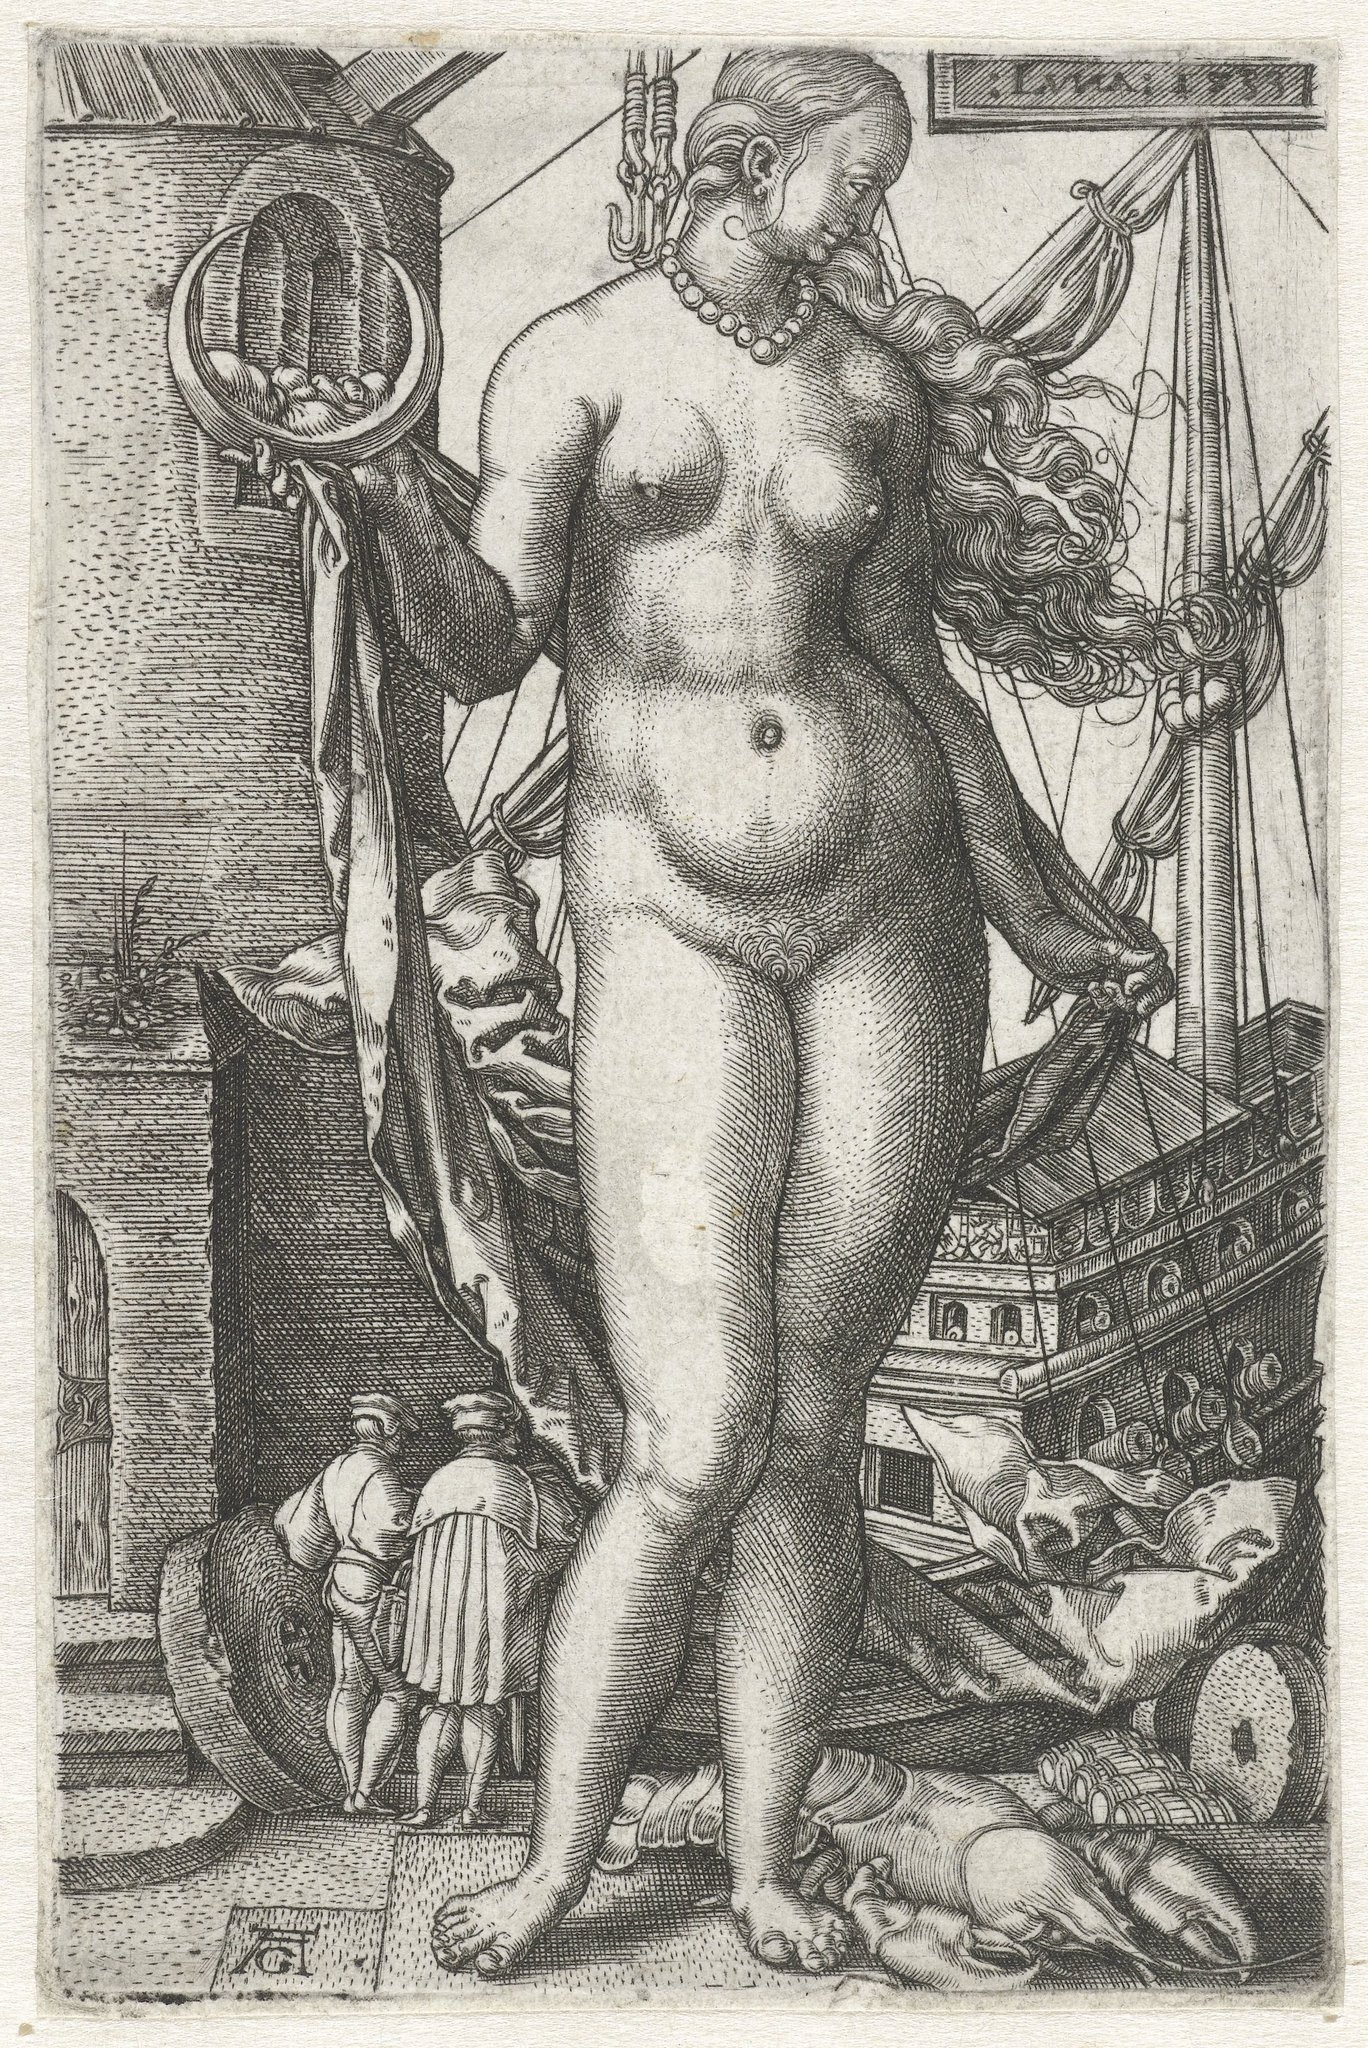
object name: print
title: Diana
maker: heinrich aldegrever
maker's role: draughtsman, print maker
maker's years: 1502-1561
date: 1533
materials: paper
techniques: engraving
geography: germany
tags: diana as moon-goddess, i.e. luna (selene)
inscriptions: date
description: Diana ( Luna) naakt, met een halve maan in haar hand en bij haar voeten een kreeft. Achter haar een oorlogsschip en twee mannen bij een molensteen. Een uit een serie van zeven prenten met goden die de planeten verbeelden.